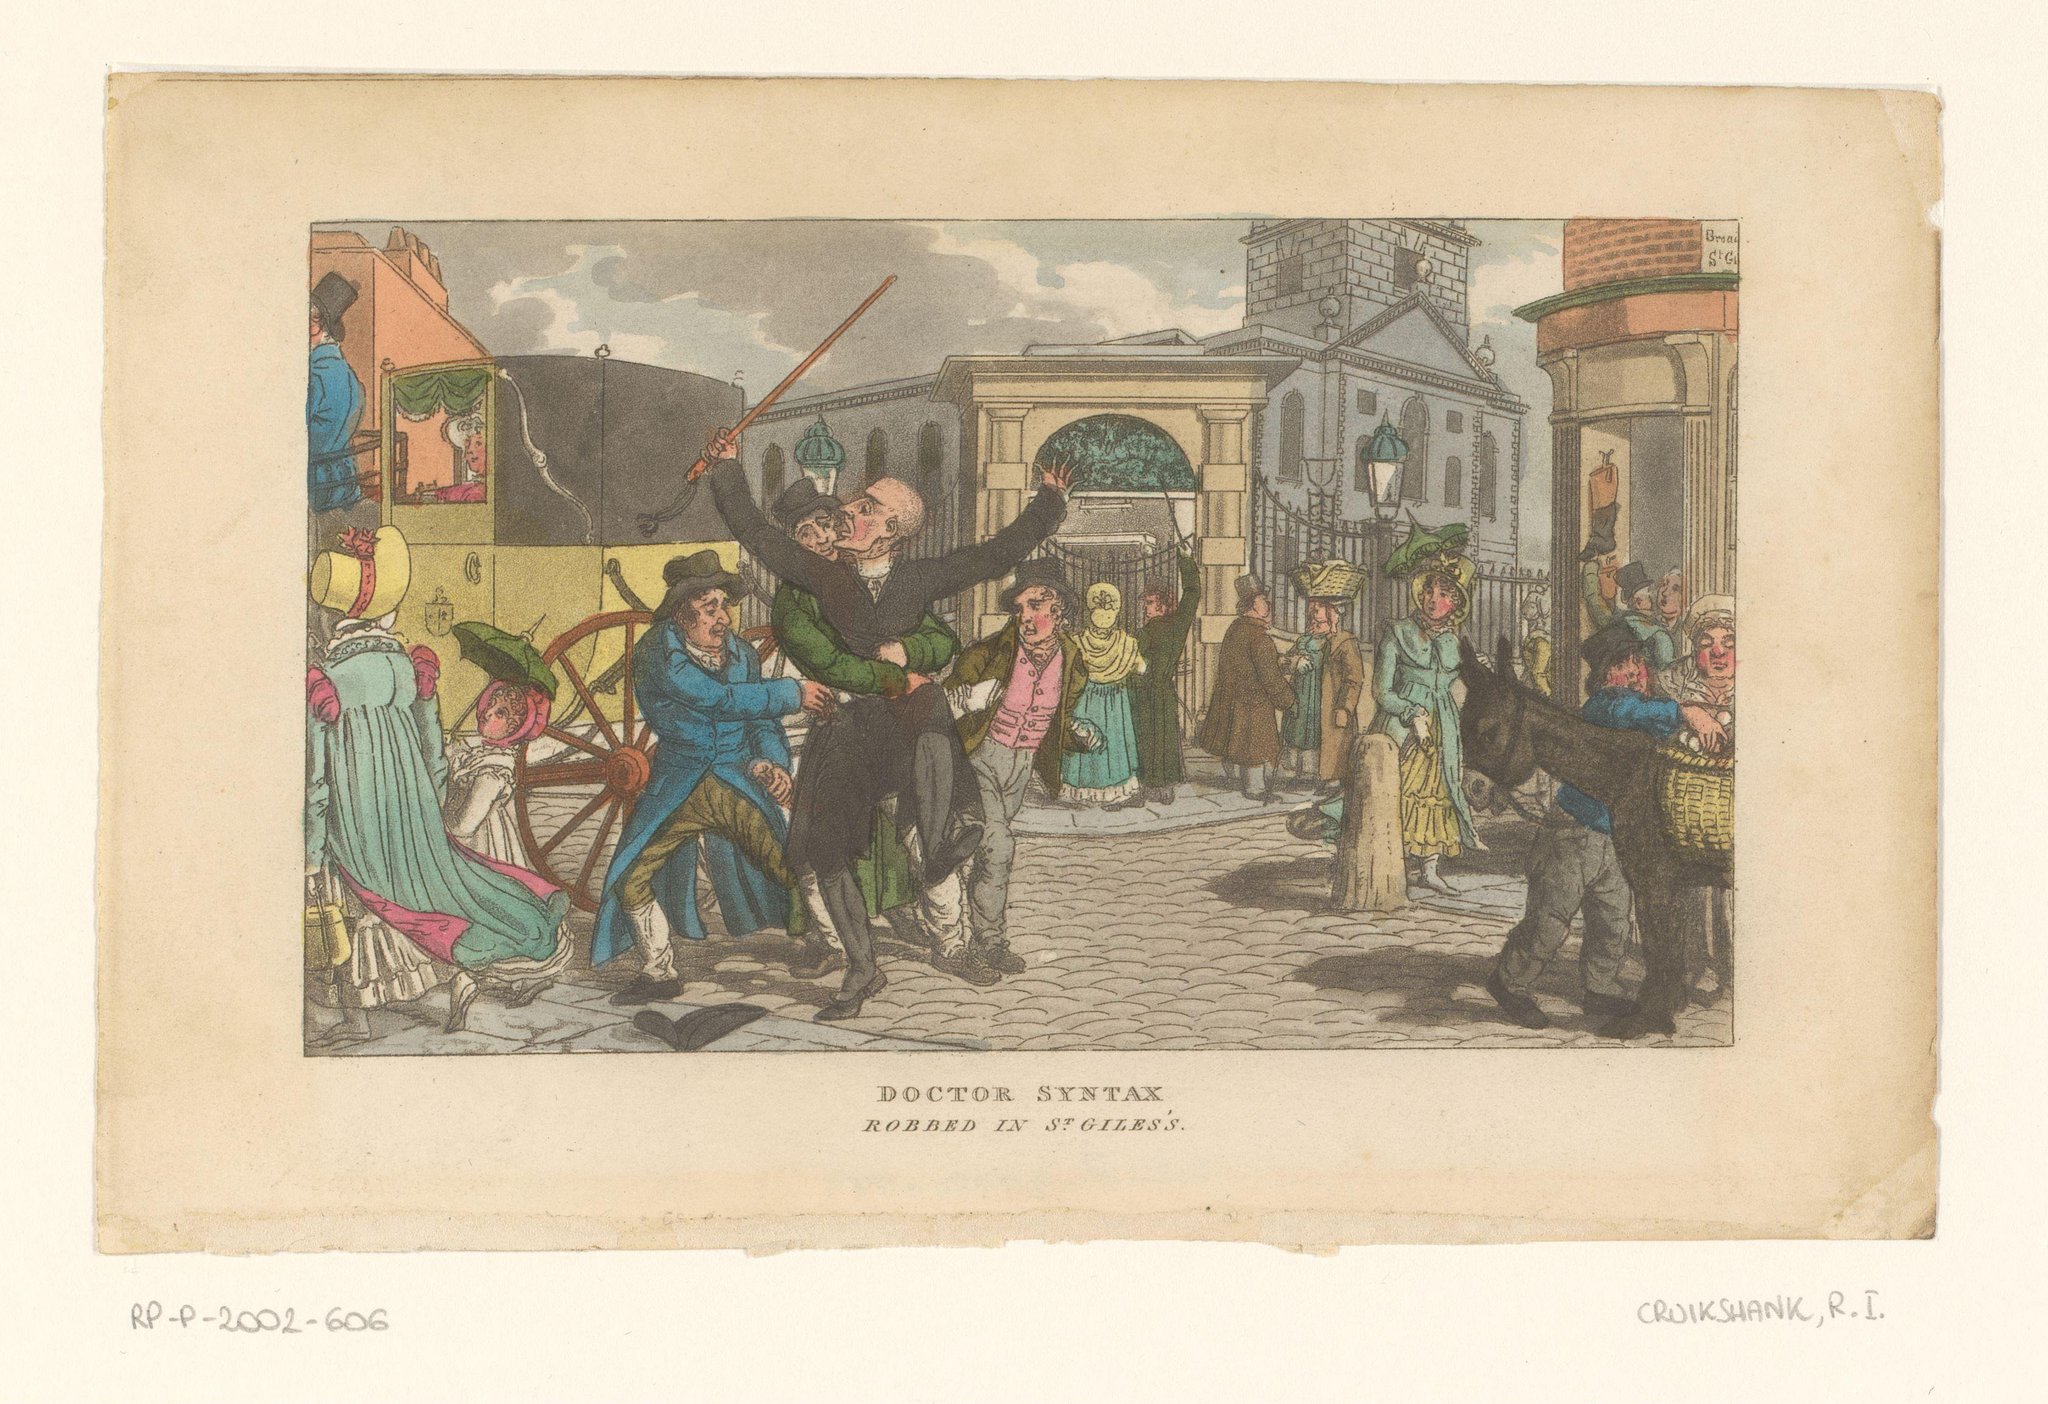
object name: cartoon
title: Doctor Syntax robbed in St. Giles's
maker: john johnston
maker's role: printer, publisher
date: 1820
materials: paper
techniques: aquatint, etching, hand coloring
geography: london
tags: names of literary characters, robbery, street (+ city(-scape) with figures, staffage), london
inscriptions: collector's mark: Lugt 2228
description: Prent ook gebruikt in: The tour of Doctor Syntax through London, or the pleasures and miseries of the metropolis. A poem. Londen: John Johnston, 1820. William Combe schreef verschillende 'tours' van Doctor Syntax, maar deze publicatie is vermoedelijk niet door hem geschreven.